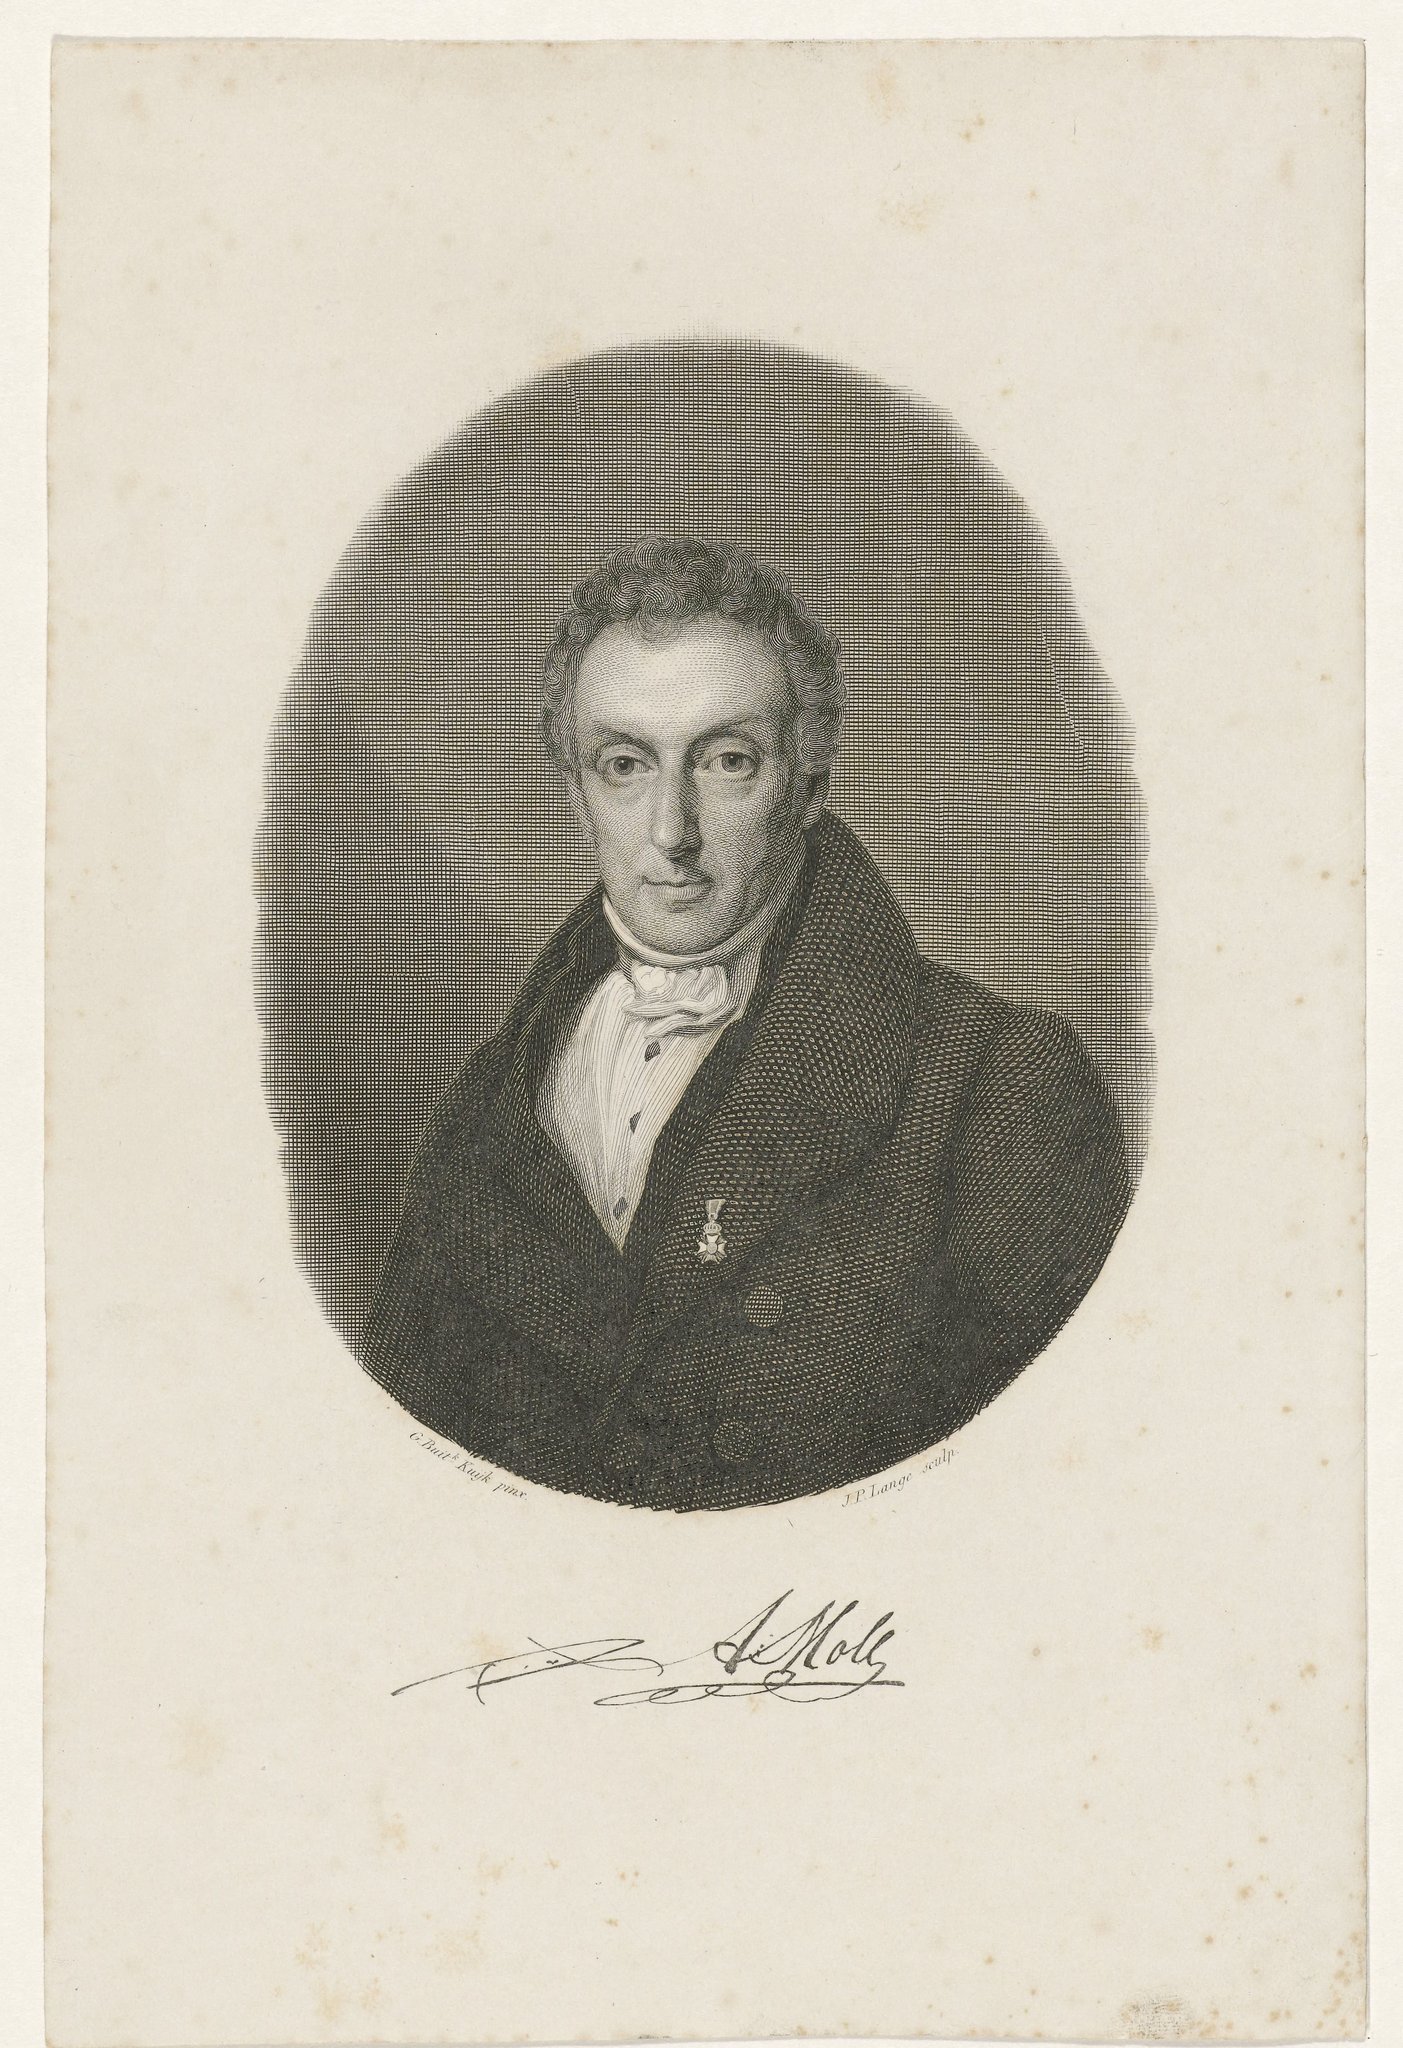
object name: print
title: Portret van Anthonij Moll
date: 1820-1849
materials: paper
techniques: engraving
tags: arnhem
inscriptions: collector's mark: Lugt 2228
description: Portretbuste in ovaal naar links van Anthonij Moll, arts en schrijver, met ridderorde op het revers.